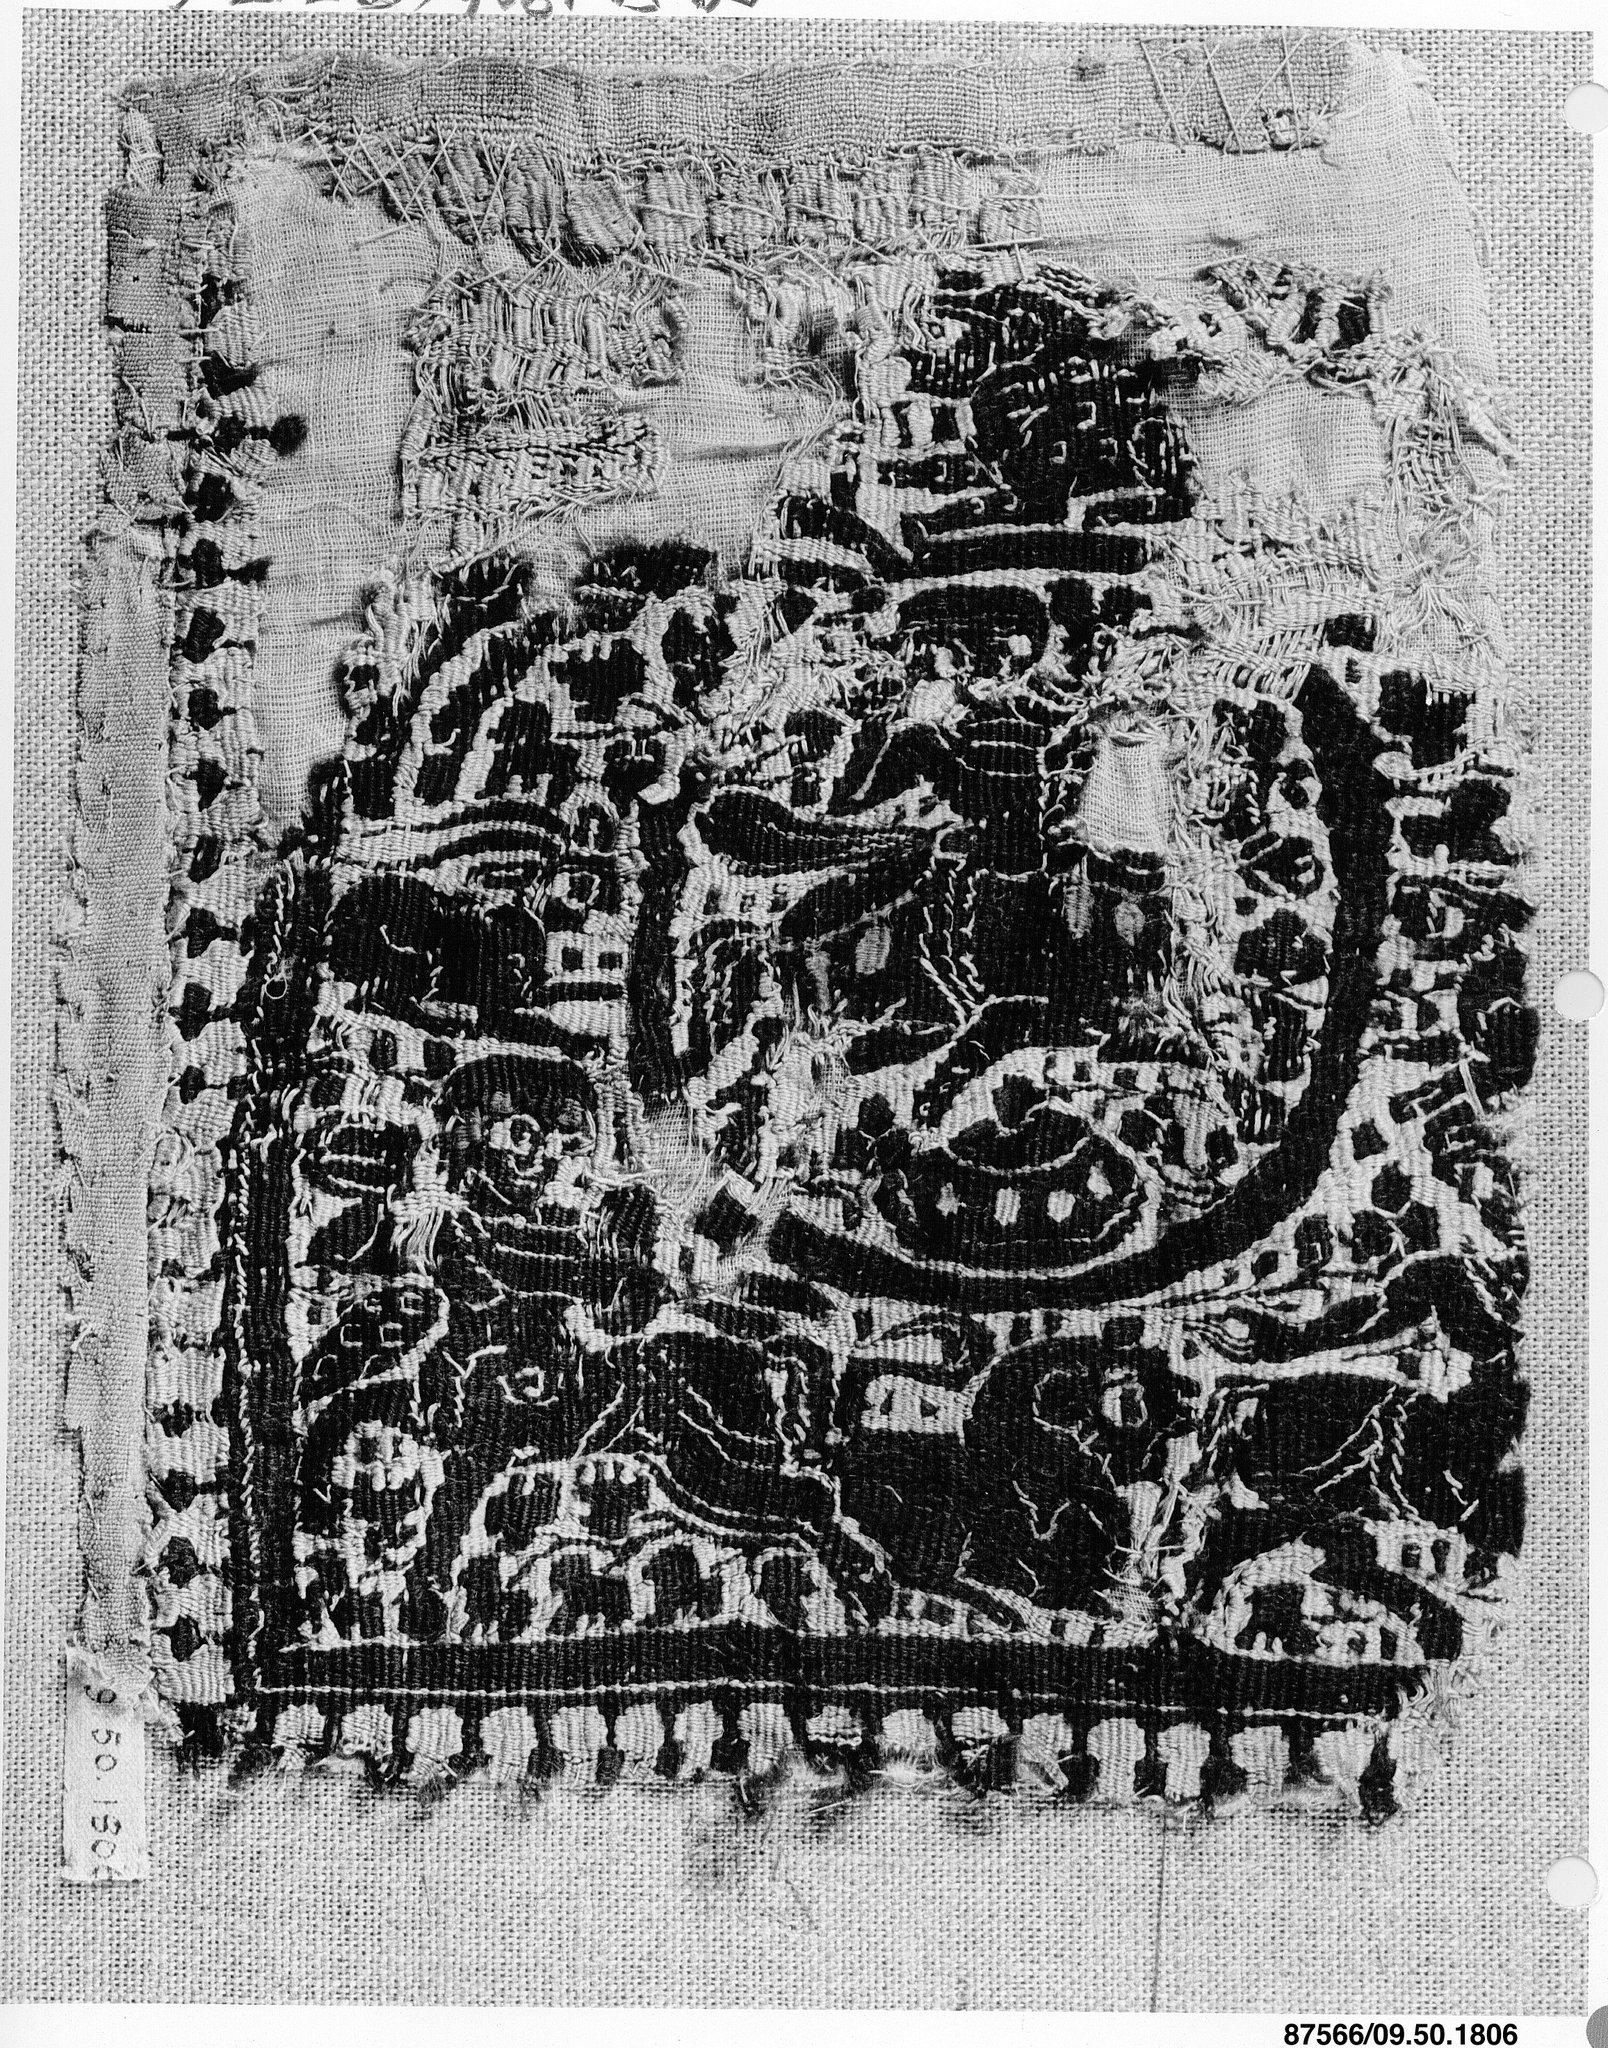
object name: textile fragment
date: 301-500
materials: linen, wool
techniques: weave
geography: egypt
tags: animals,horses